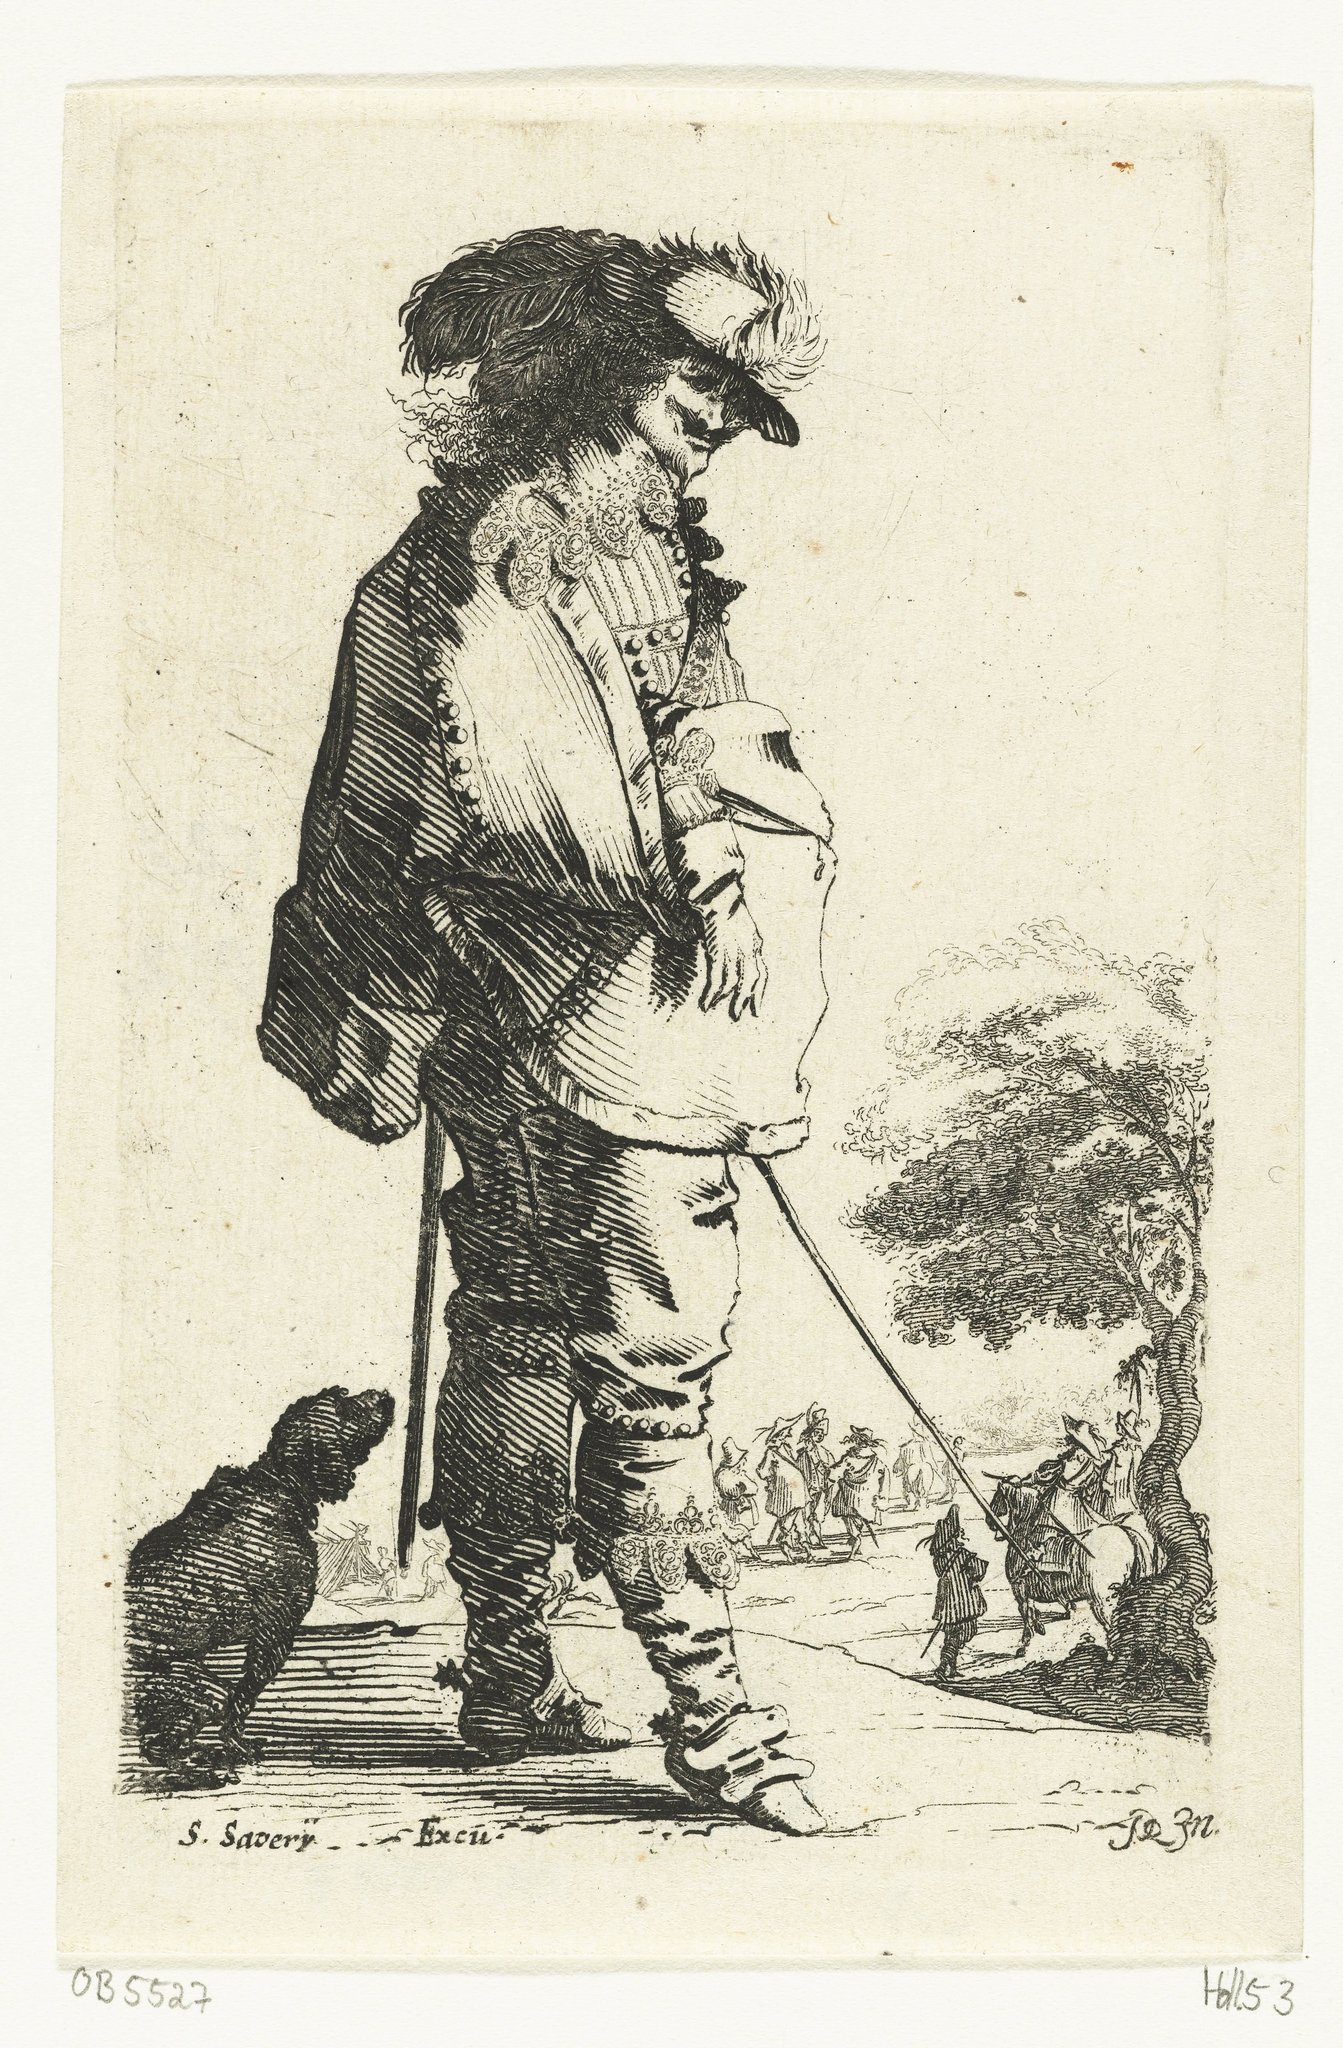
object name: costume print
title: Staande cavalier met stok, achter hem een hond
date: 1633-1665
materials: paper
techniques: engraving, etching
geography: amsterdam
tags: warfare; military affairs (+ cavalry, horsemen), clothes, costume (+ men's clothes), dog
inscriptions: collector's mark: Lugt 2228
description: De prent maakt deel uit van een tiendelige serie prenten met voorstellingen van cavaliers en welgestelde vrouwen, gekleed volgens de Nederlandse mode ca. 1625-1630.